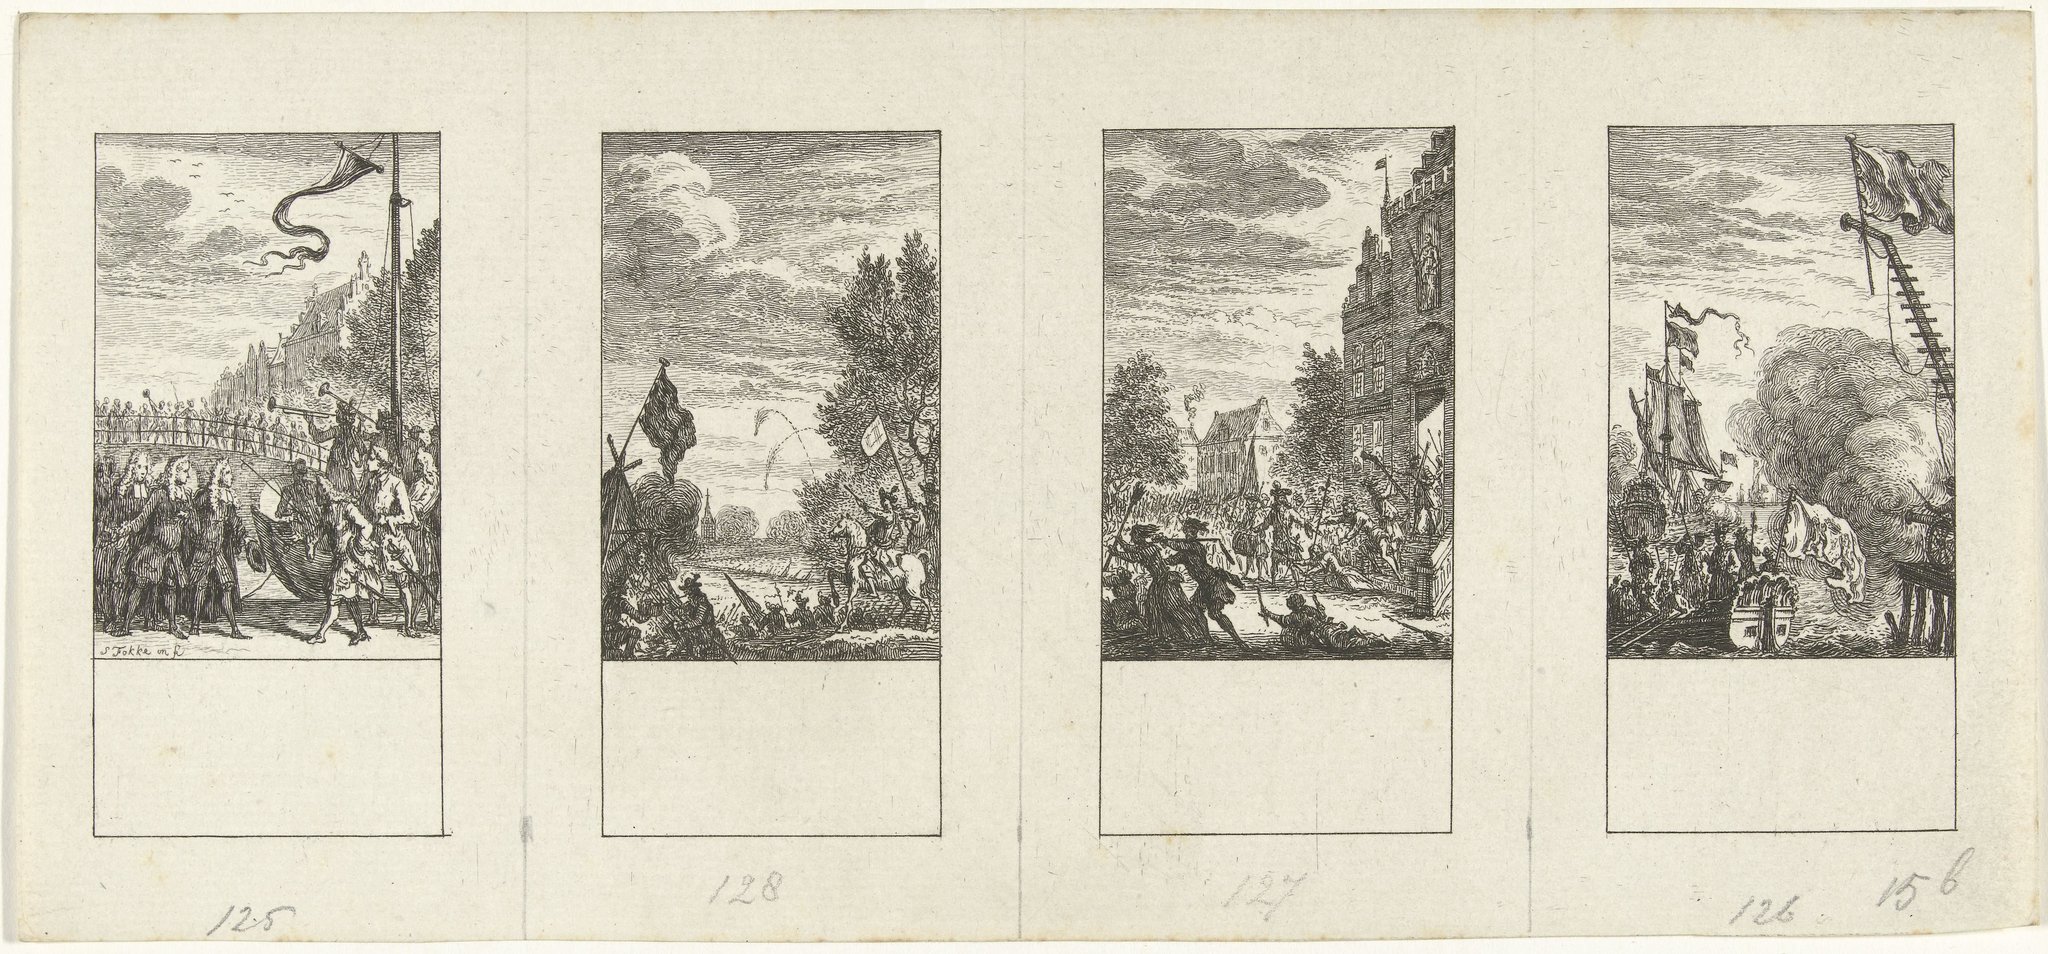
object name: print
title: Vier episodes uit de vaderlandse geschiedenis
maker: simon fokke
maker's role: draughtsman, print maker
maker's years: 1712-1784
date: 1722-1784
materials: paper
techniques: etching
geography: amsterdam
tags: vienna, charles vi (holy roman emperor), berlin, frederik i koning van pruisen, historical events and situations, historical persons (portraits and scenes from the life)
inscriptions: collector's mark: Lugt 2228, number: ‘125, 128, 127, 126’